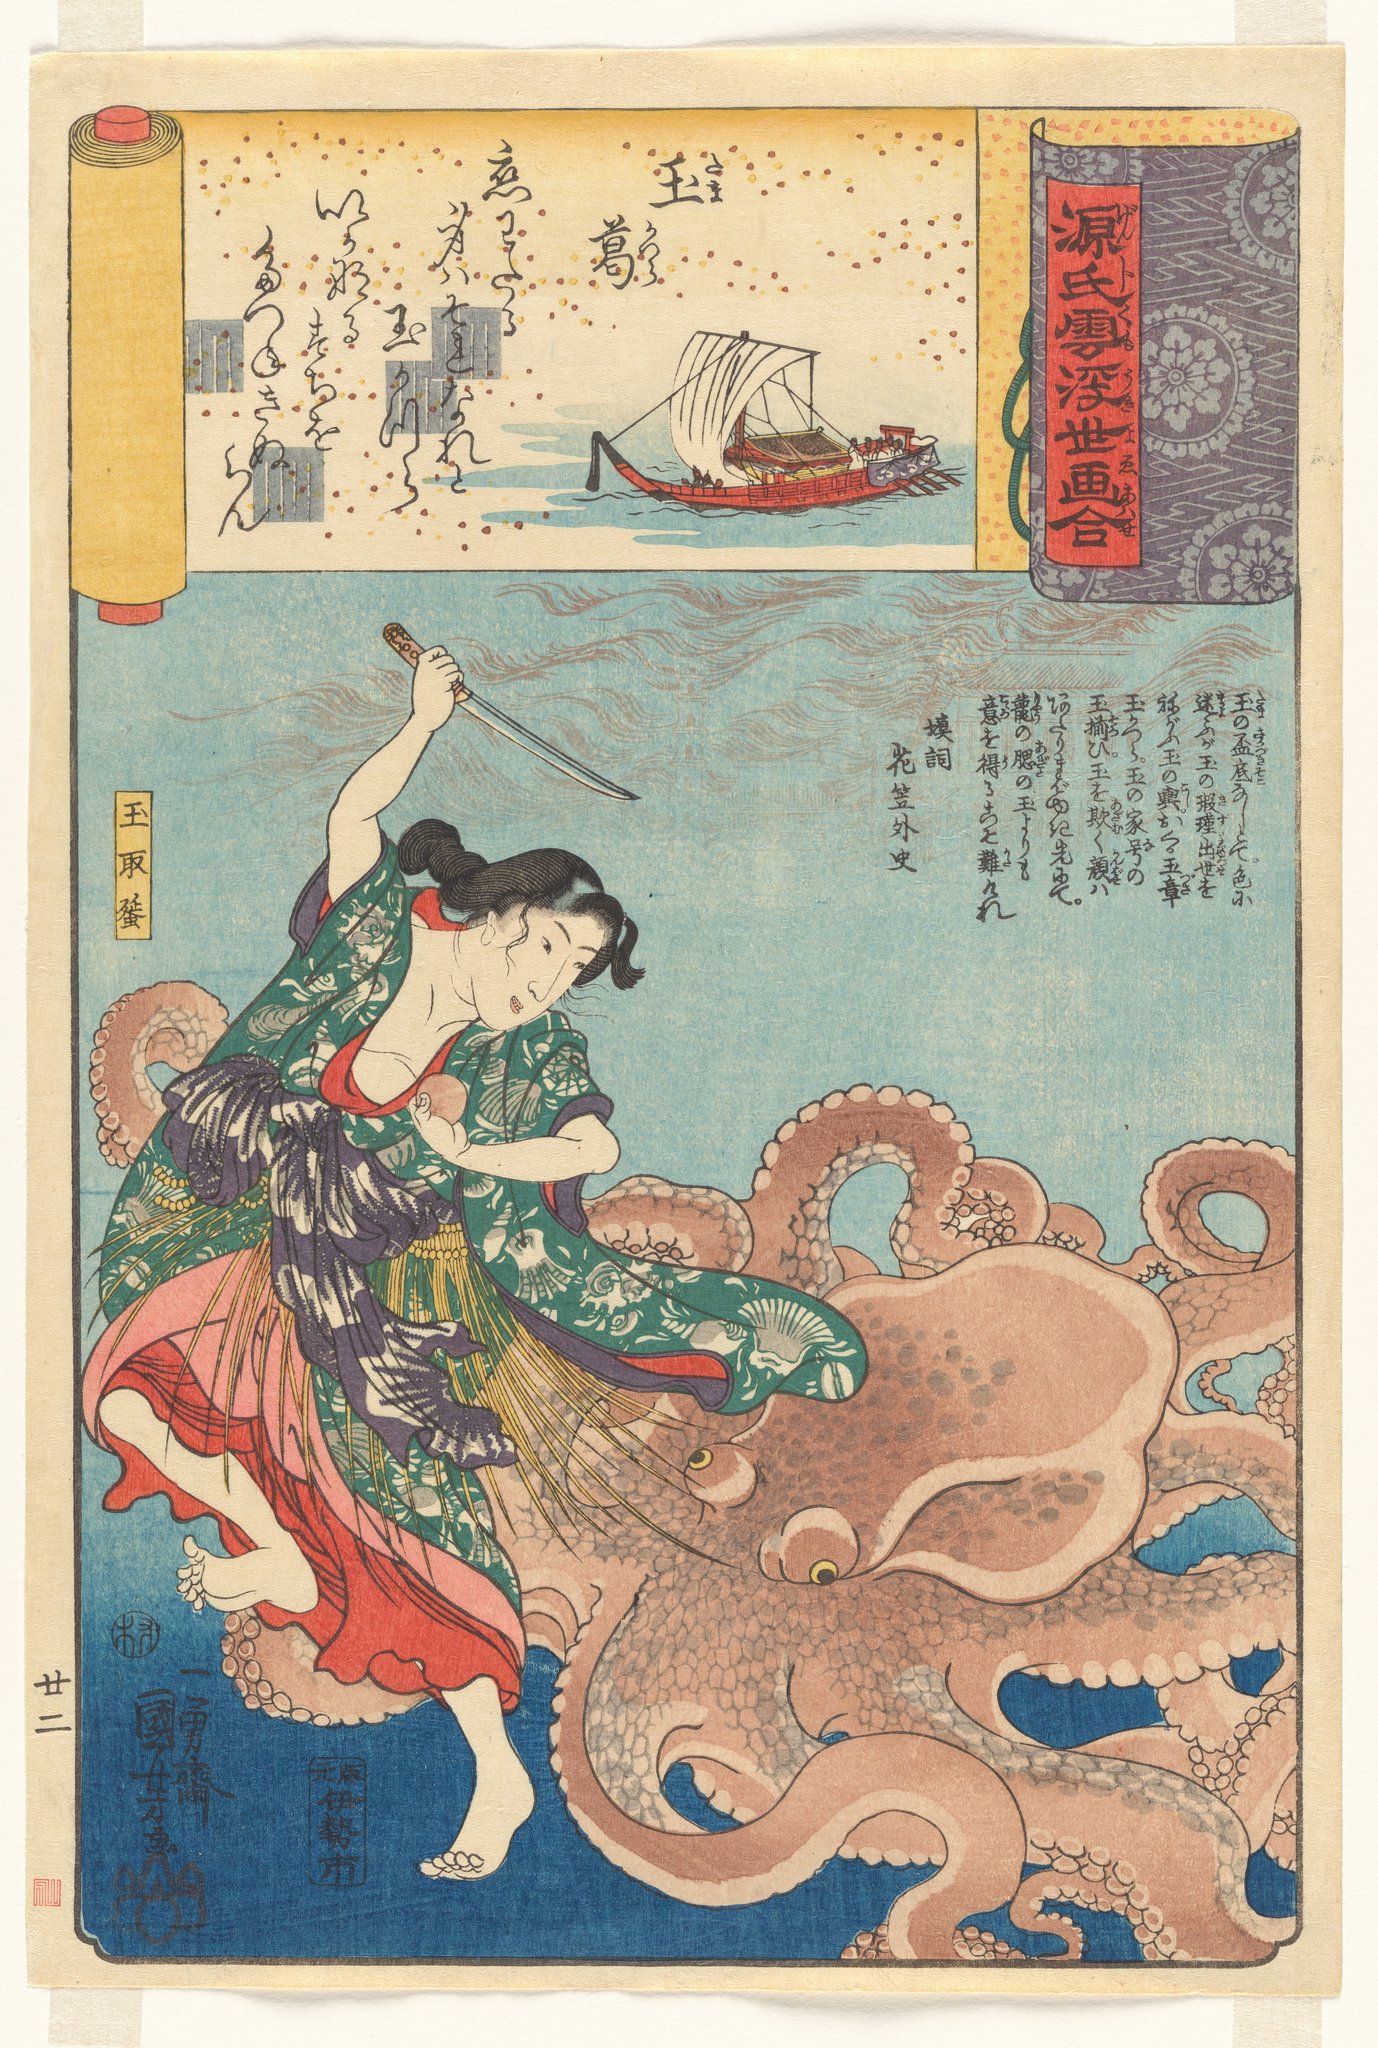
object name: print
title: “‘A Lovely Garland’ (Tamakazura): Tamatori-ama,” from the series Scenes amid Genji Clouds Matched with Ukiyo-e Pictures (Genji-gumo ukiyo e-awase)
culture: japanese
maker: utagawa kuniyoshi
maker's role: artist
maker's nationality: japanese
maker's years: 1797-1861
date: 1845-1846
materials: ink, paper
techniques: nishiki e